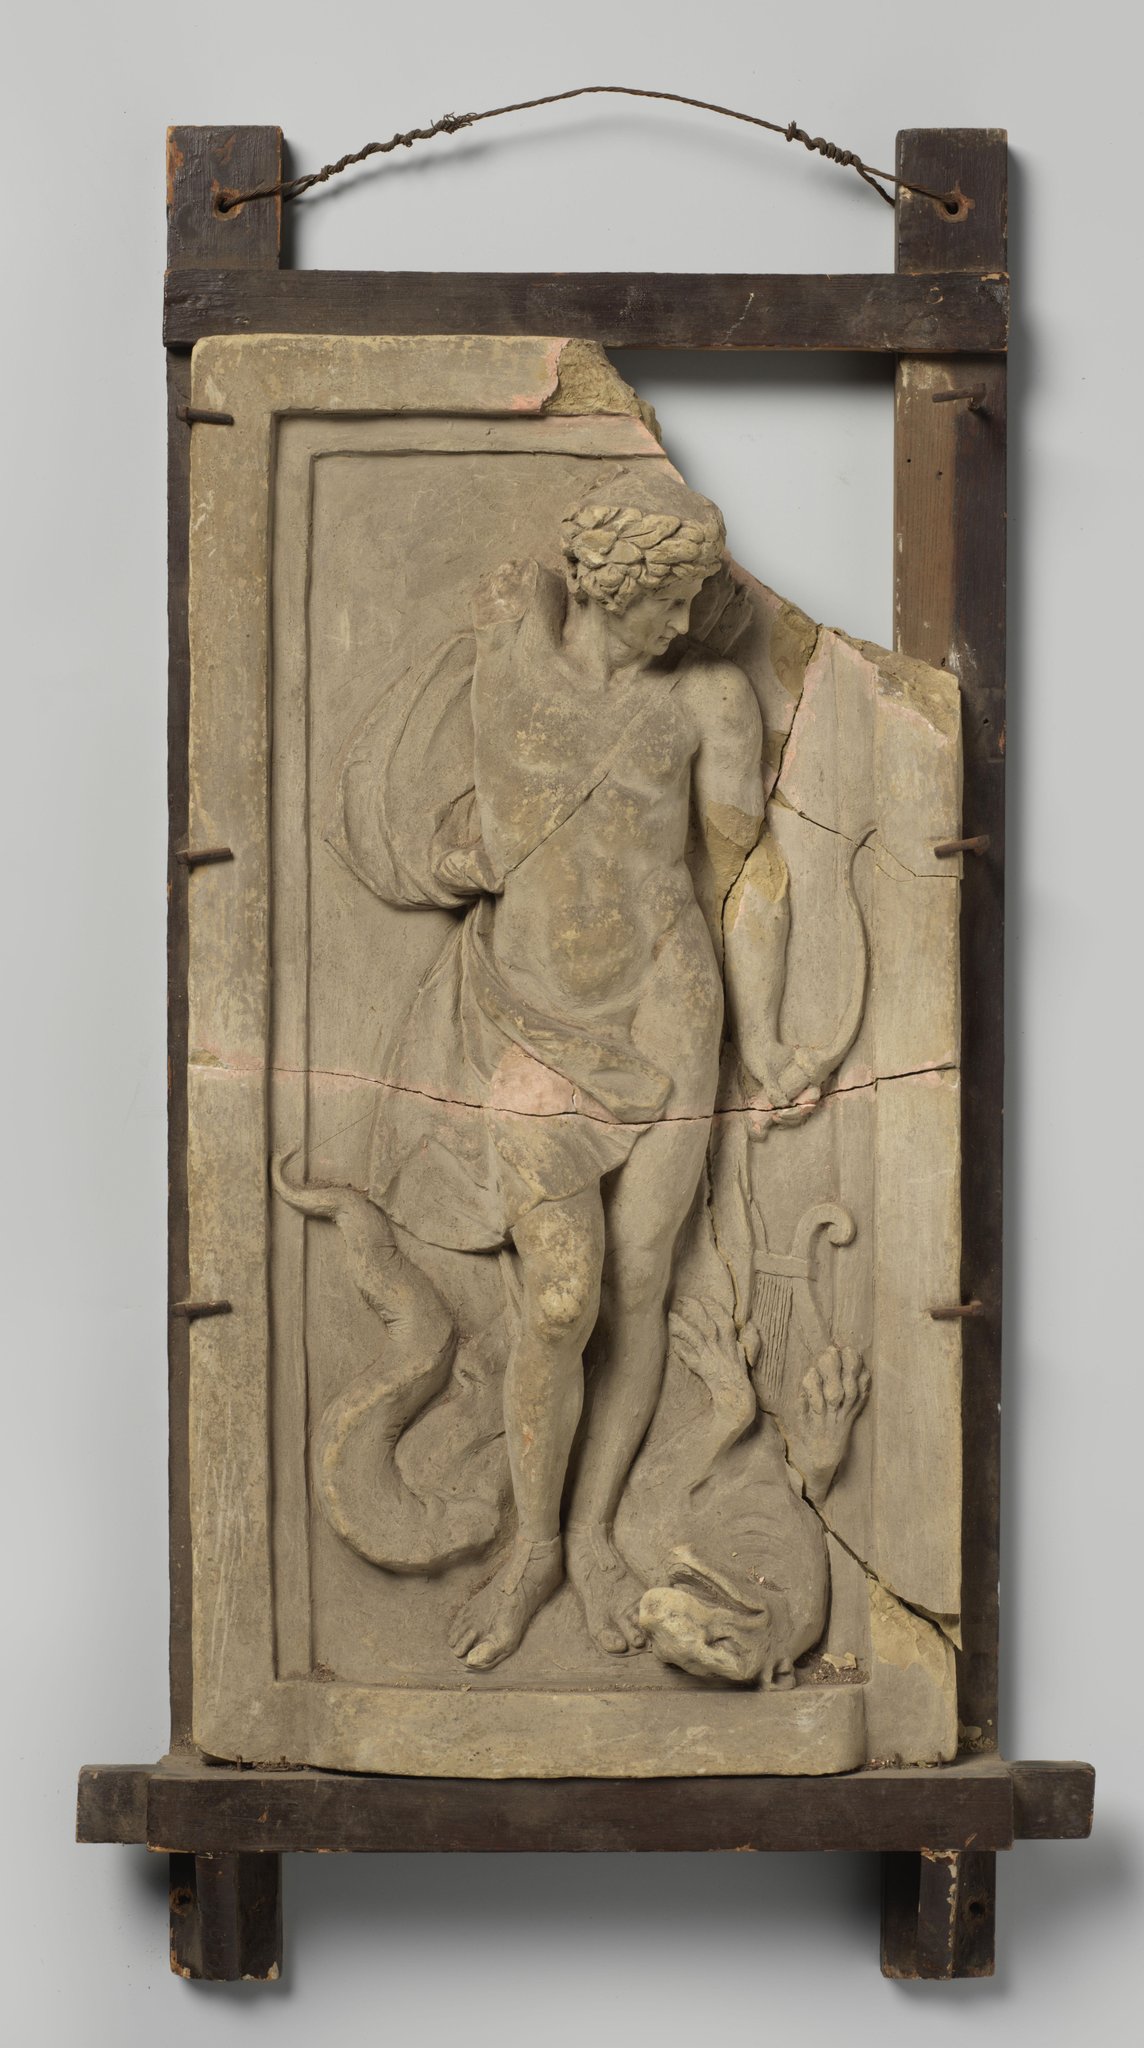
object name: relief sculpture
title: Reliëf in grijze ongebakken klei, voorstellende Apollo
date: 1800-1899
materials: clay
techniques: firing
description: Reliëf in grijze gebakken klei, voorstellende Apollo, gemodelleerd naar een der modellen voor het marmeren reliëf in de Z.W. hoek van de galerij van het Paleis-Stadhuis te Amsterdam door Artus Quellinus of zijn atelier. Staande, naakte figuur, de rechterknie iets doorgezakt, het linkerbeen gestrekt. In de linkerhand een boog met de rechter een pijl uit de koker, die op de rug achter de linkerschouder hangt, grijpend. Een kleine mantel bedekt het schaamdeel, en wordt ter hoogte van de buik opgehouden. Het hoofd is naar links neerwaarts gericht, omkranst met lauweren; sandalen aan de voeten. Achter de figuur kronkelt een op de rug liggende python. Hierachter, ter rechterzijde een lier. Lijst aan boven- en onderzijde met onversierd profiel, onderkant flauw uitgeschulpt. Rechterarm ontbreekt, eveneens een fragment van het opwapperende manteltje. Barst door rechterbovenhoek en stukken van de lijst afgeschilferd.